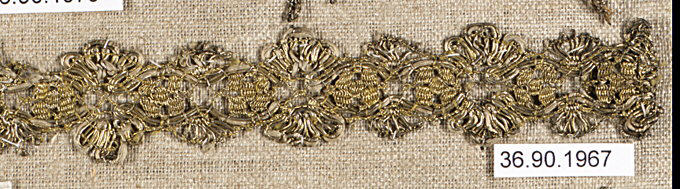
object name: piece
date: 1801-1900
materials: metal thread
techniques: lace